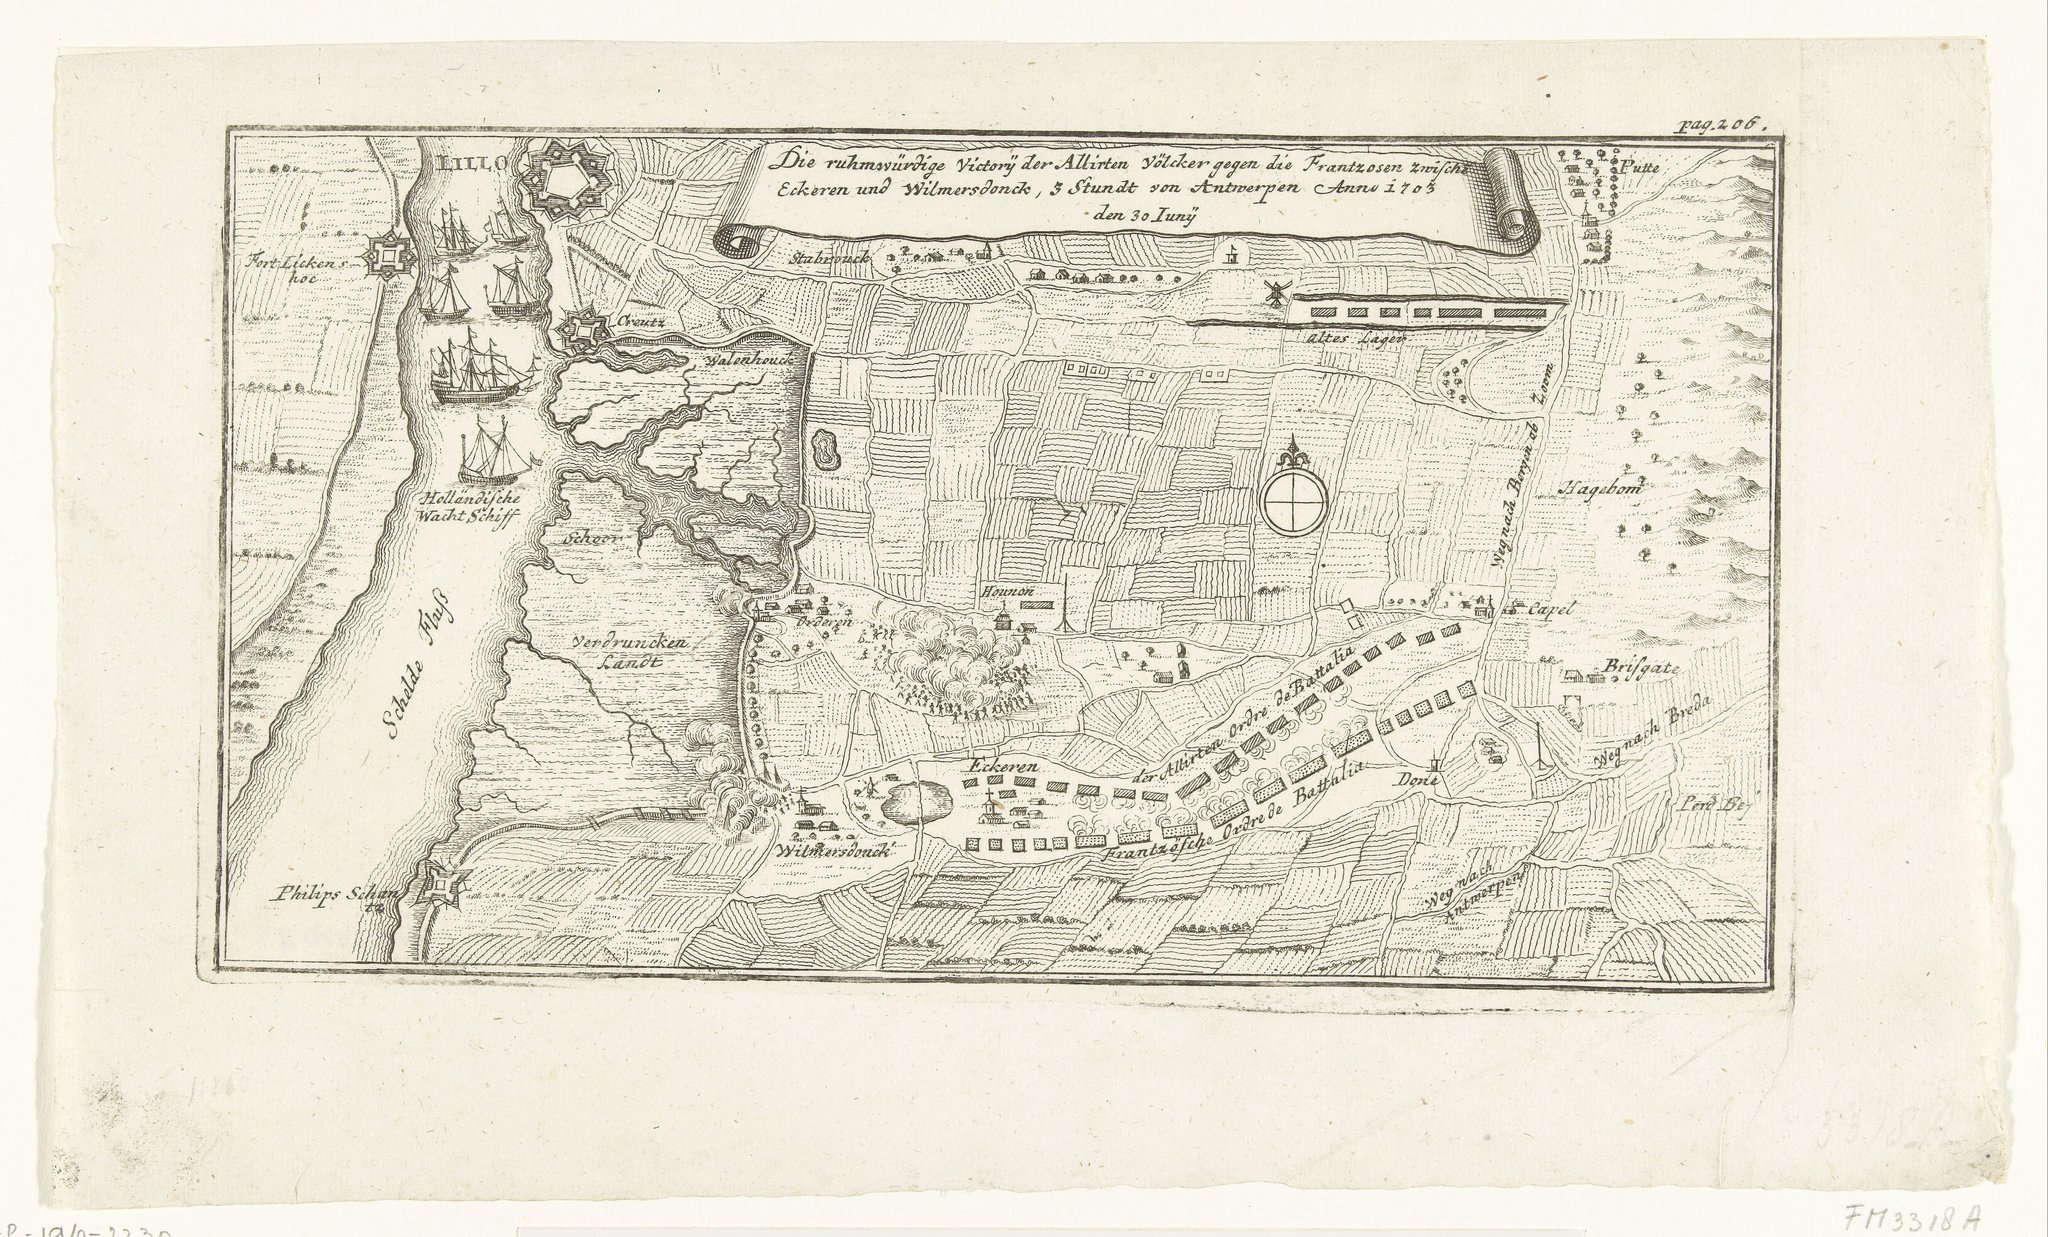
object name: print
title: Kaart van de veldslag bij Ekeren, 1703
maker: Anonymous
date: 1703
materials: paper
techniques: etching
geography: germany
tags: the hague, maps of separate countries or regions, battle (+ land forces)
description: Kaart van de veldslag bij Ekeren aan de Schelde tussen de Nederlandse troepen onder Jacob II van Wassenaer Obdam en de Fransen, 30 juni 1703. Gemerkt rechtsboven: pag. 206.